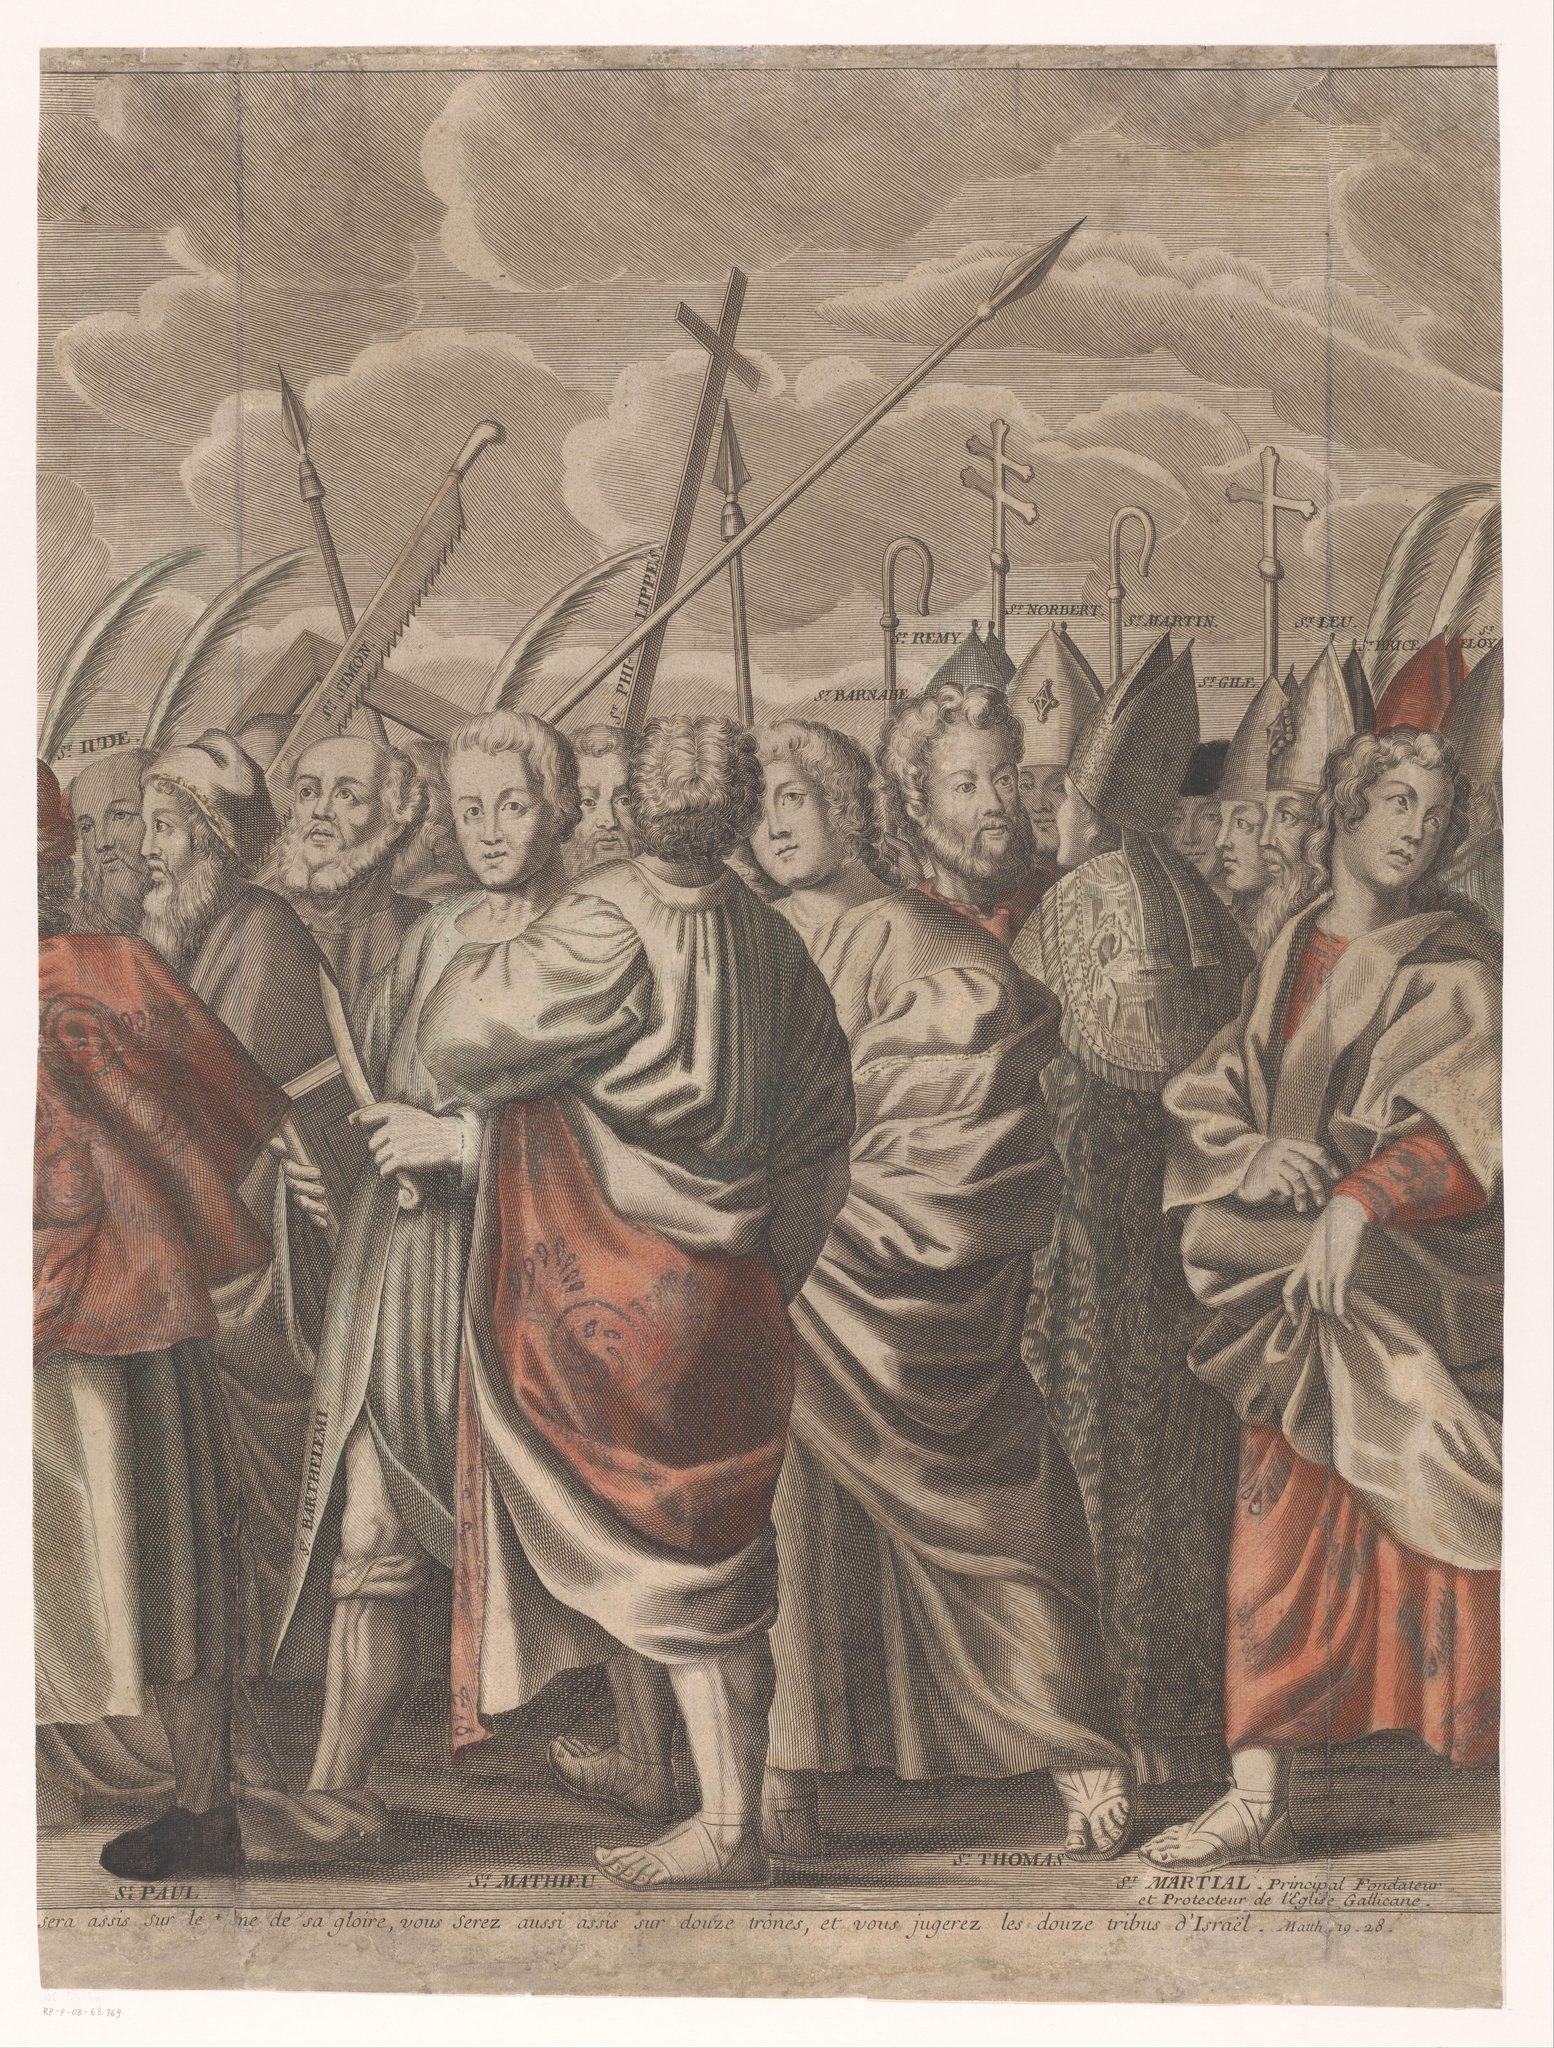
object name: print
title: Triomftocht van Christus met figuren uit het Oude en Nieuwe Testament (zevende deel)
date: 1687-1694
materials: paper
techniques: engraving, etching, hand coloring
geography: france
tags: the apostle thomas; possible attributes: book, chalice, girdle, heart, lance or spear, scroll, square, stones, the apostle and evangelist matthew (mattheus); possible attributes: angel, axe, book, halberd, pen and inkhorn, purse, scroll, square, sword, triumphs (allegorical and symbolic), martial(is), bishop of limoges; possible attributes: staff, the apostle paul of tarsus; possible attributes: book, scroll, sword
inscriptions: collector's mark: Lugt 2228